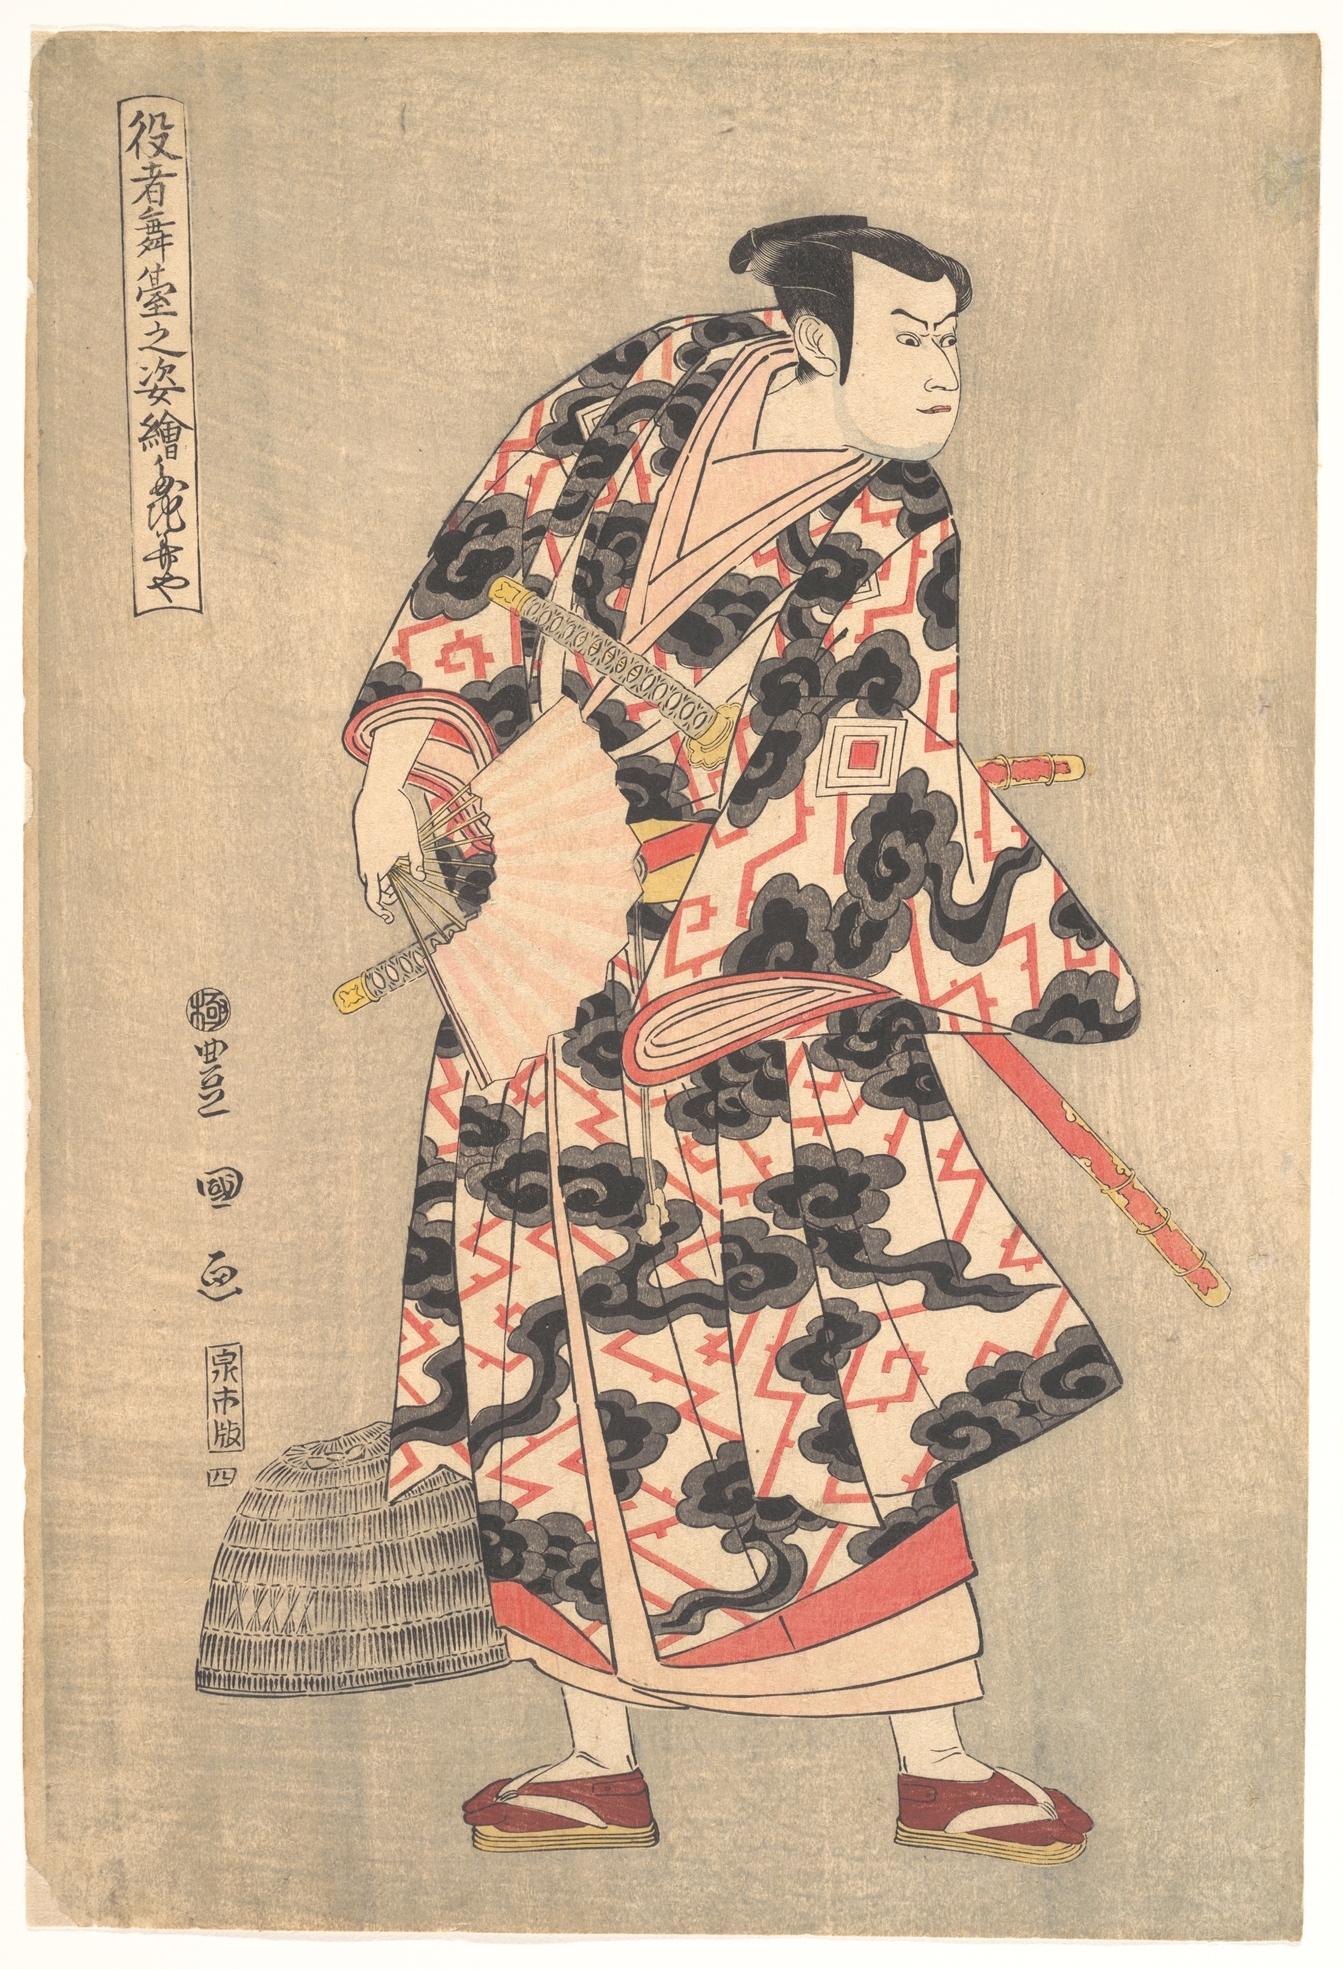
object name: print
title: The Actor Ichikawa Yaozo III in the Role of Fuwa Banzaemon from the Play "Ukiyozuka hiyoku no inazuma"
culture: japanese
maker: utagawa toyokuni i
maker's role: artist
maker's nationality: japanese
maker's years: 1769-1825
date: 1774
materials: ink, paper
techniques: woodblock print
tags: fans,swords,men,actors